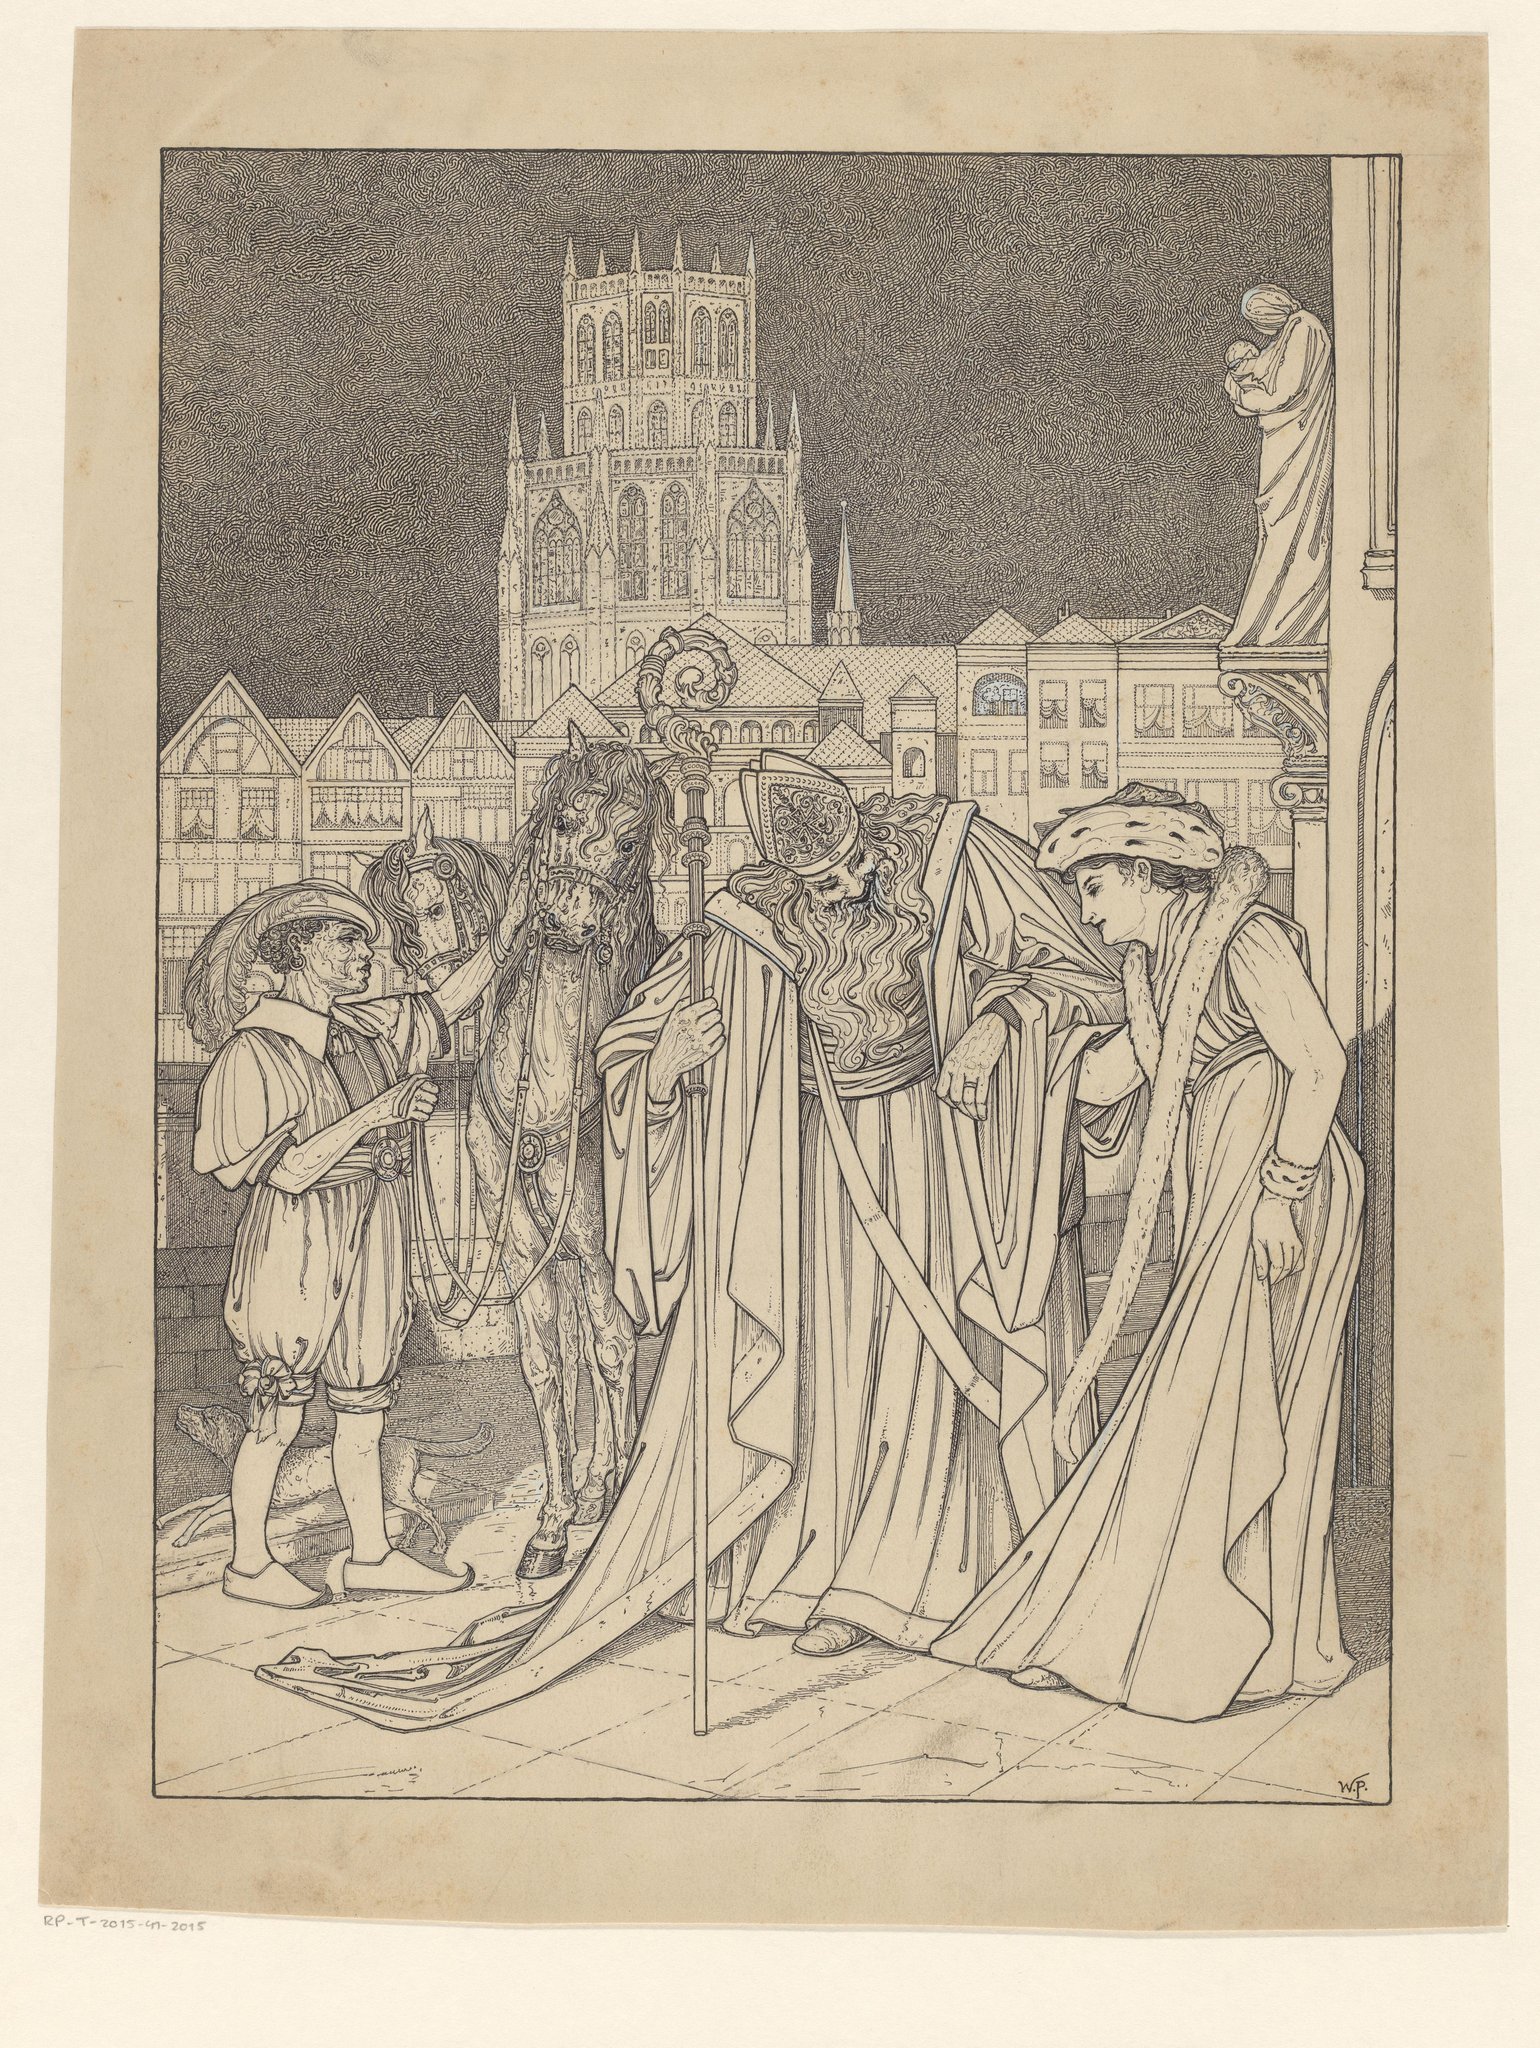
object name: drawing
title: Sint Nicolaas met een vrouw, Piet en twee paarden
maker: willem pothast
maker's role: draughtsman, print maker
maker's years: 1877-1916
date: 1887-1916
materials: paint, ink, paper, pencil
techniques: brush, pen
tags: the bishop nicholas of myra (or bari); possible attributes: anchor, boat, three golden balls (on a book), three purses, three children in a tub, three maidens, church (exterior), horse, walking arm in arm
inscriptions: signature: ‘W.P.’, collector's mark: Lugt 2228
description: Sint Nicolaas staat met zijn staf in de hand in een stedelijke omgeving. Hij ondersteunt een vrouw gekleed in een lange mantel met hoed en een sjaal van bont. Naast hen staat Piet met twee paarden. In de achtergrond zijn huizen en een kathedraal te zien.